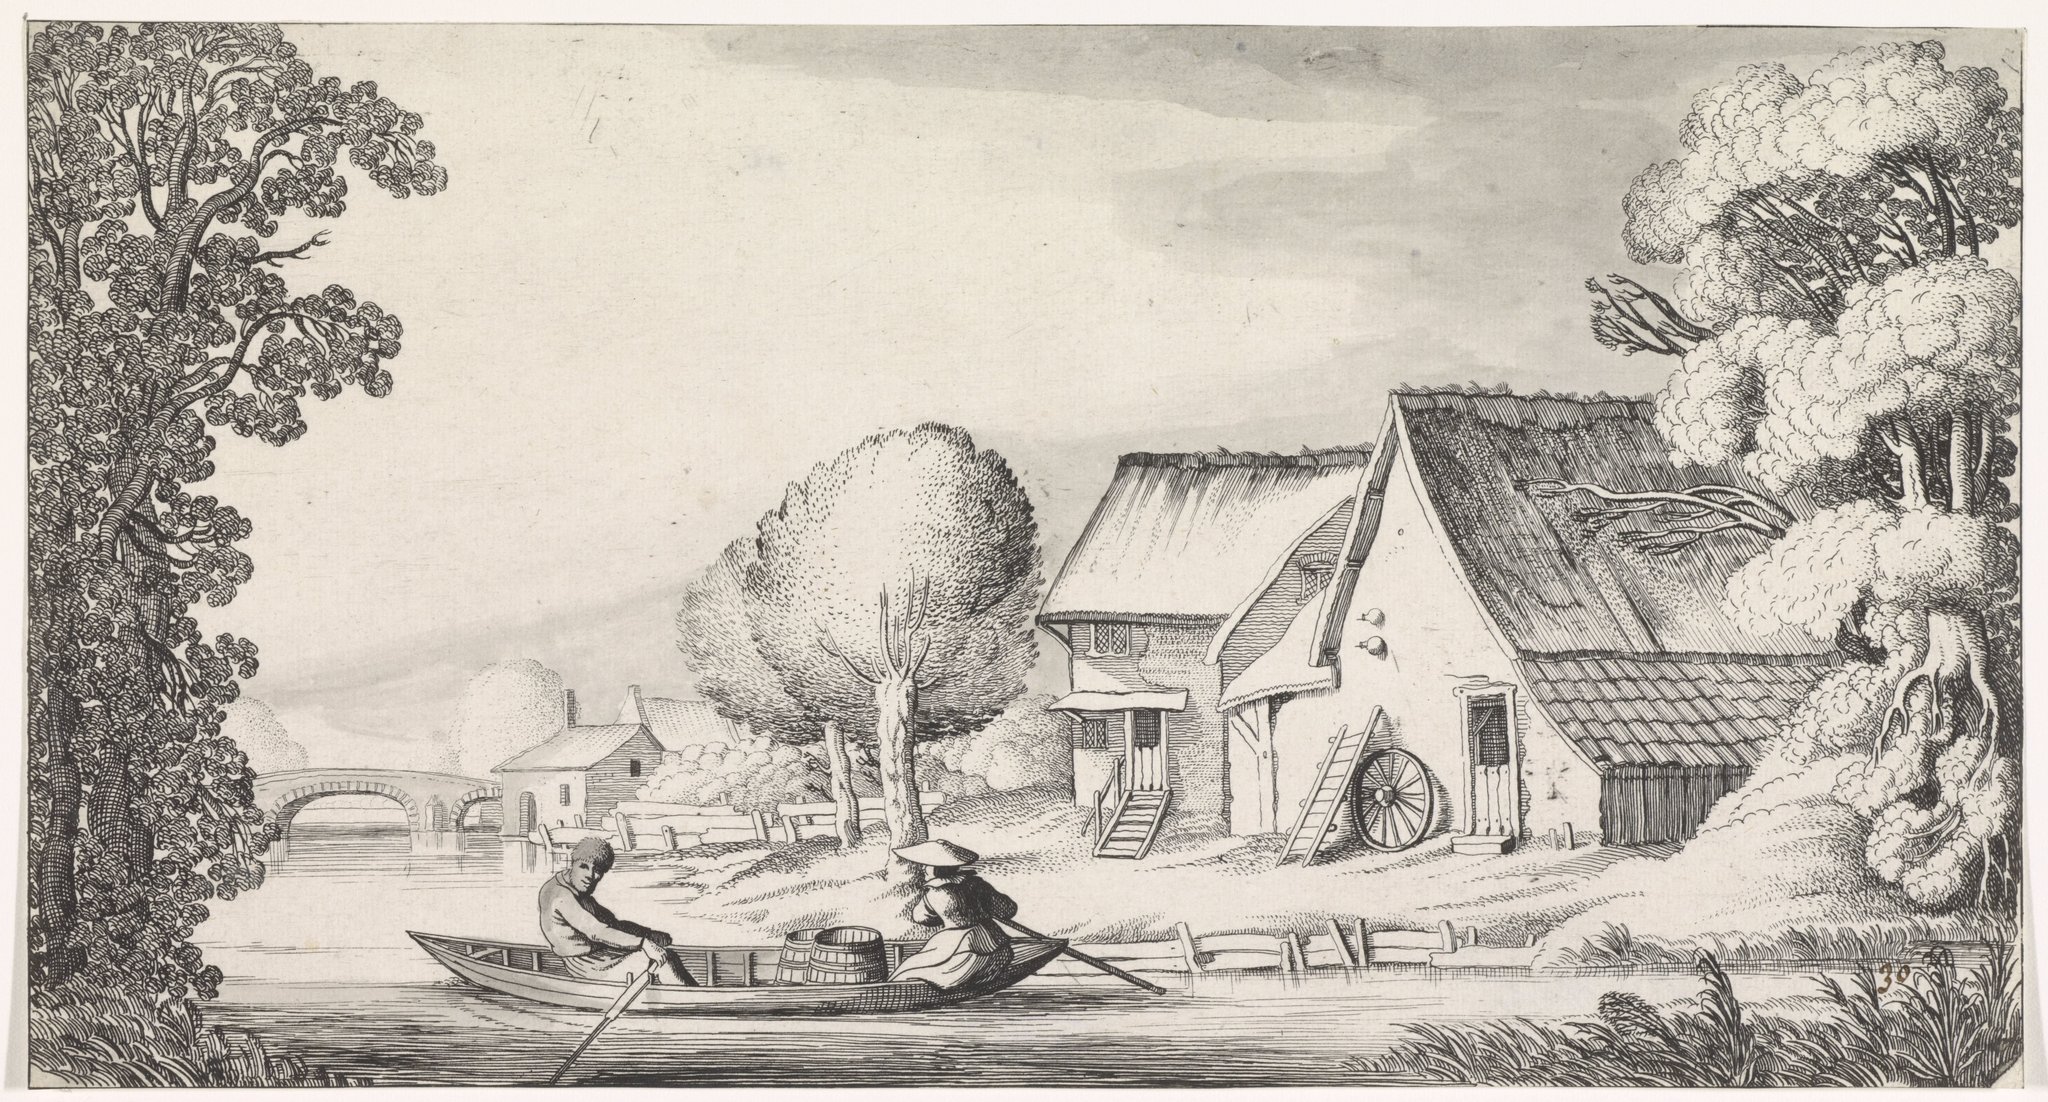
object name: print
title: Boer en boerin in een roeiboot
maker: jan van de velde (ii)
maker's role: draughtsman, painter, print maker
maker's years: 1593-1641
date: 1639-1641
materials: ink, paper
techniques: brush, etching, pen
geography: northern netherlands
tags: wooden container: barrel, cask, bucket, river, landscape with bridge, viaduct or aqueduct, rowing-boat, canoe, etc., farm (building)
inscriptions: number: ‘30’, collector's mark: Lugt 1120, collector's mark: Lugt 2228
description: Boer en boerin in een roeiboot waarin twee tonnen, op een rivier langs een boerderij. Op de achtergrond een stenen brug. 30ste prent van een serie met 36 prenten van landschappen, verdeeld over zes delen.